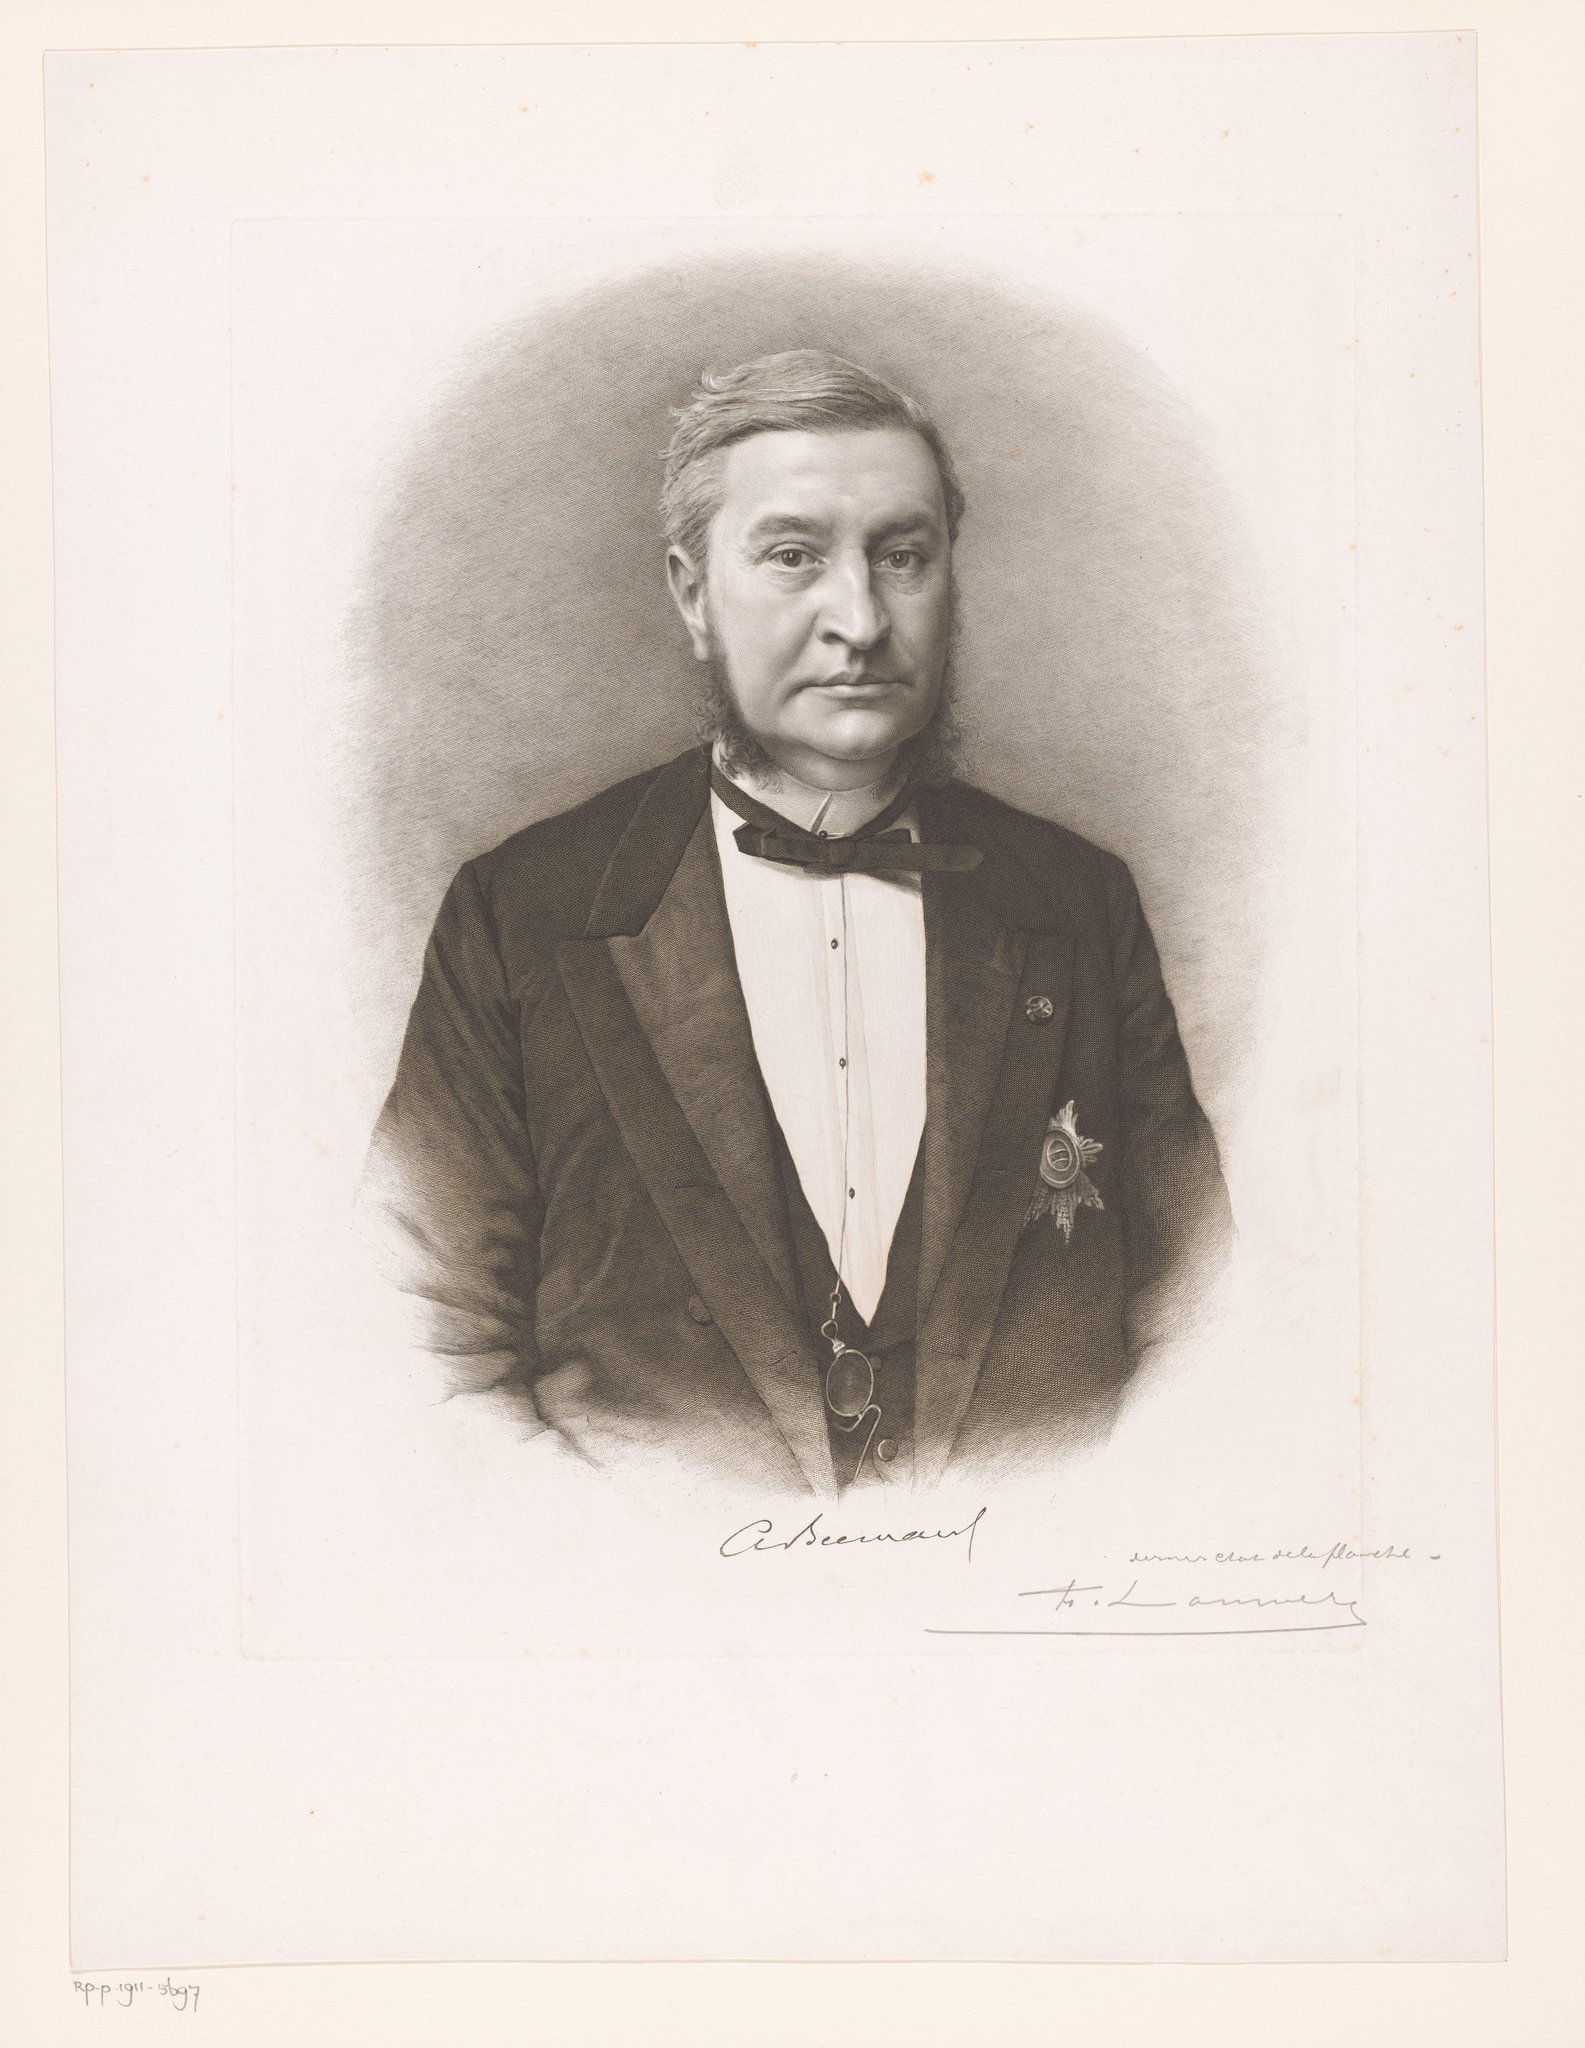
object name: print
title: A. Beernaert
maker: frans lauwers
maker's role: print maker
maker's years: 1854-1931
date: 1864-1911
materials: paper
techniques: etching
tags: politician, historical persons (+ caricature ~ portrait)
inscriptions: annotation: ‘dernier etat de la planche’, collector's mark: Lugt 2228